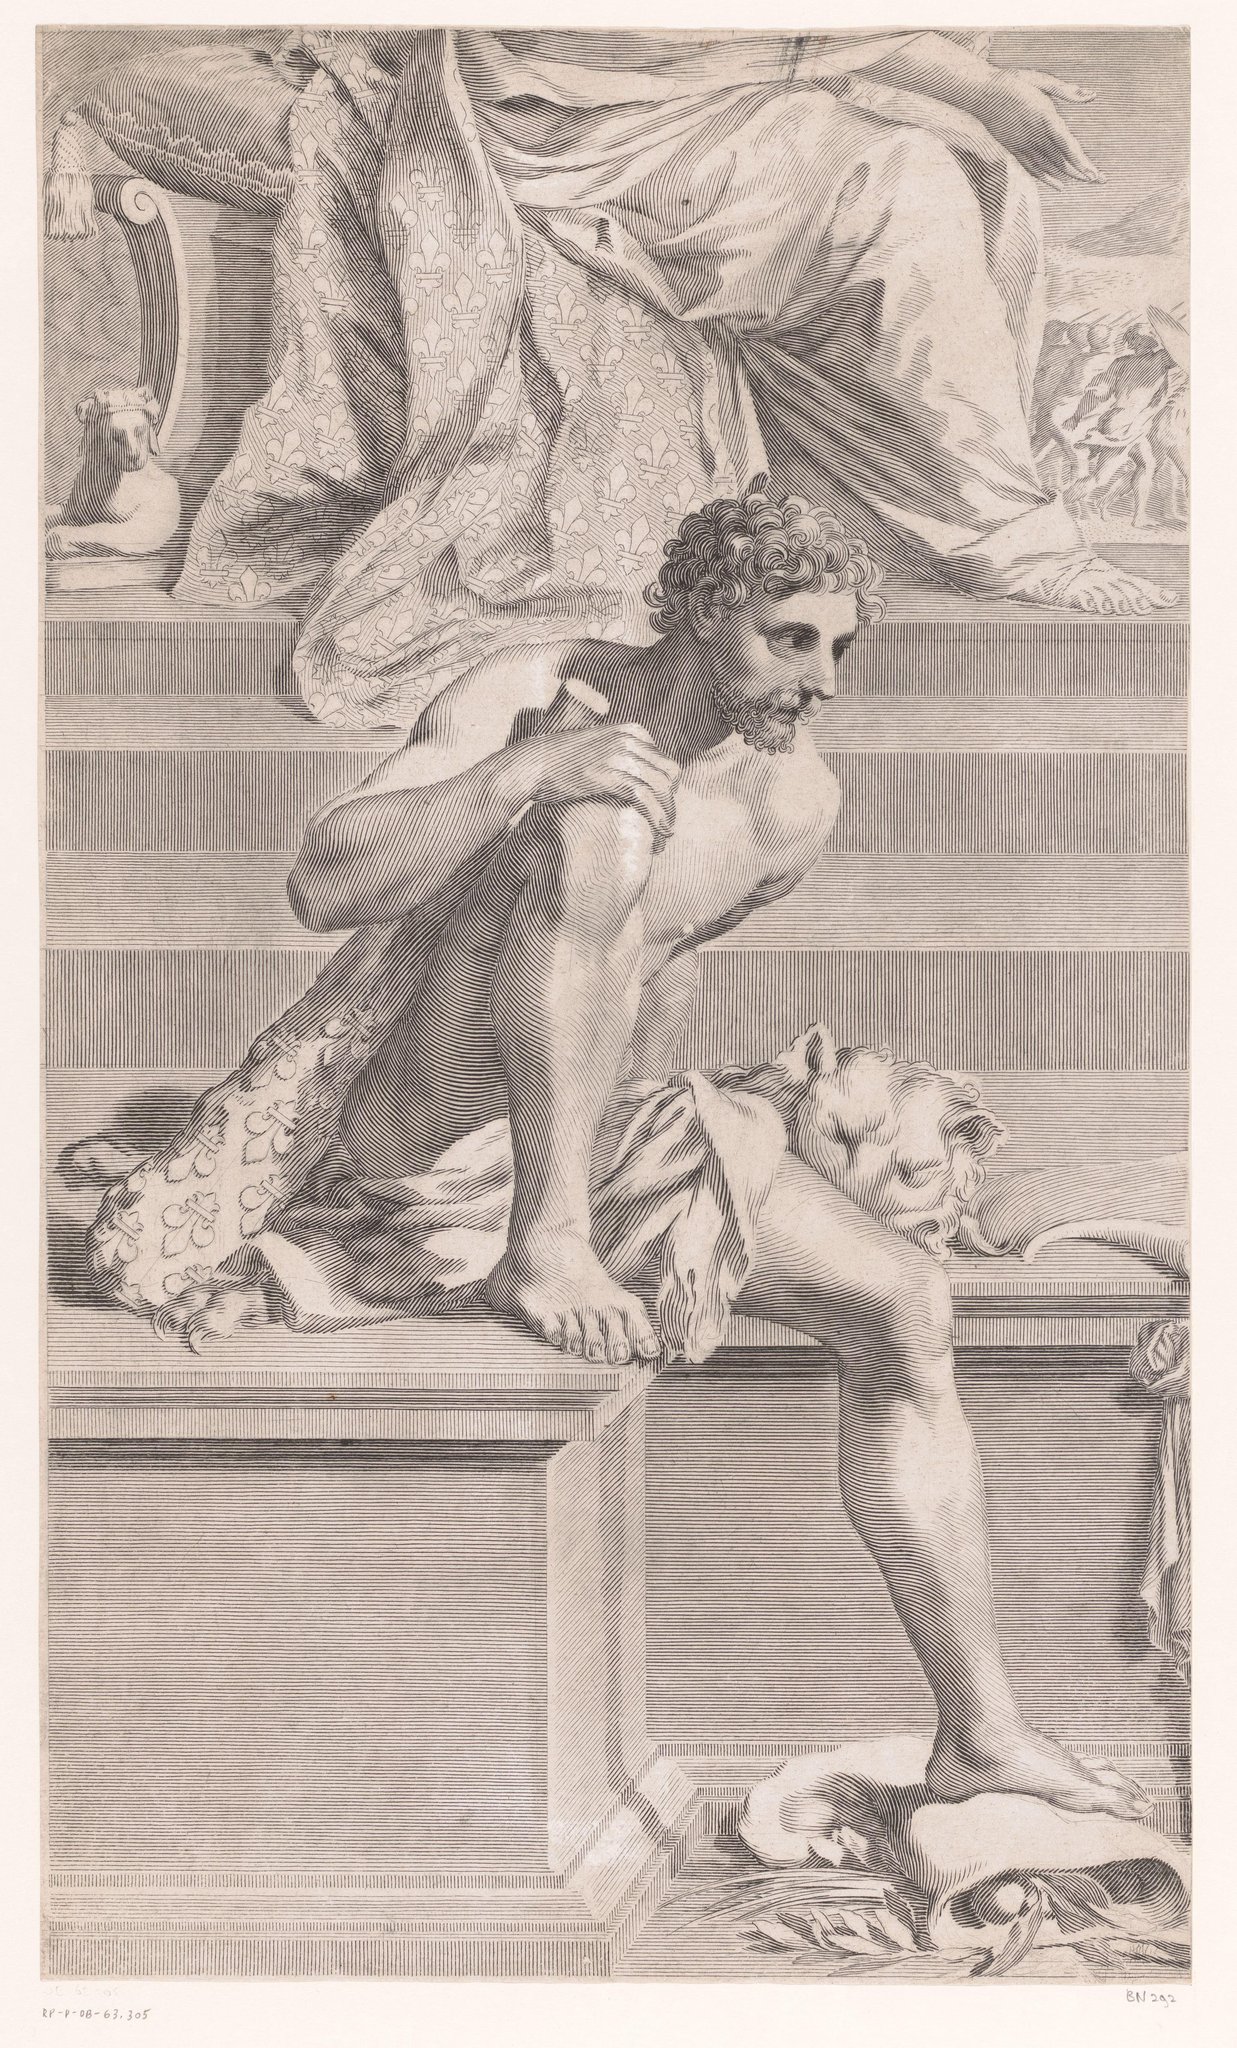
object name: print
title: These over theologie van Antoine Talon (linkermiddendeel)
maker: claude mellan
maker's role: draughtsman, print maker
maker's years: 1598-1688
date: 1648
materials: paper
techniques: engraving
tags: (story of) hercules (heracles)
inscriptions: collector's mark: Lugt 2228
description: Zittende Hercules met knots en leeuwenhuid.